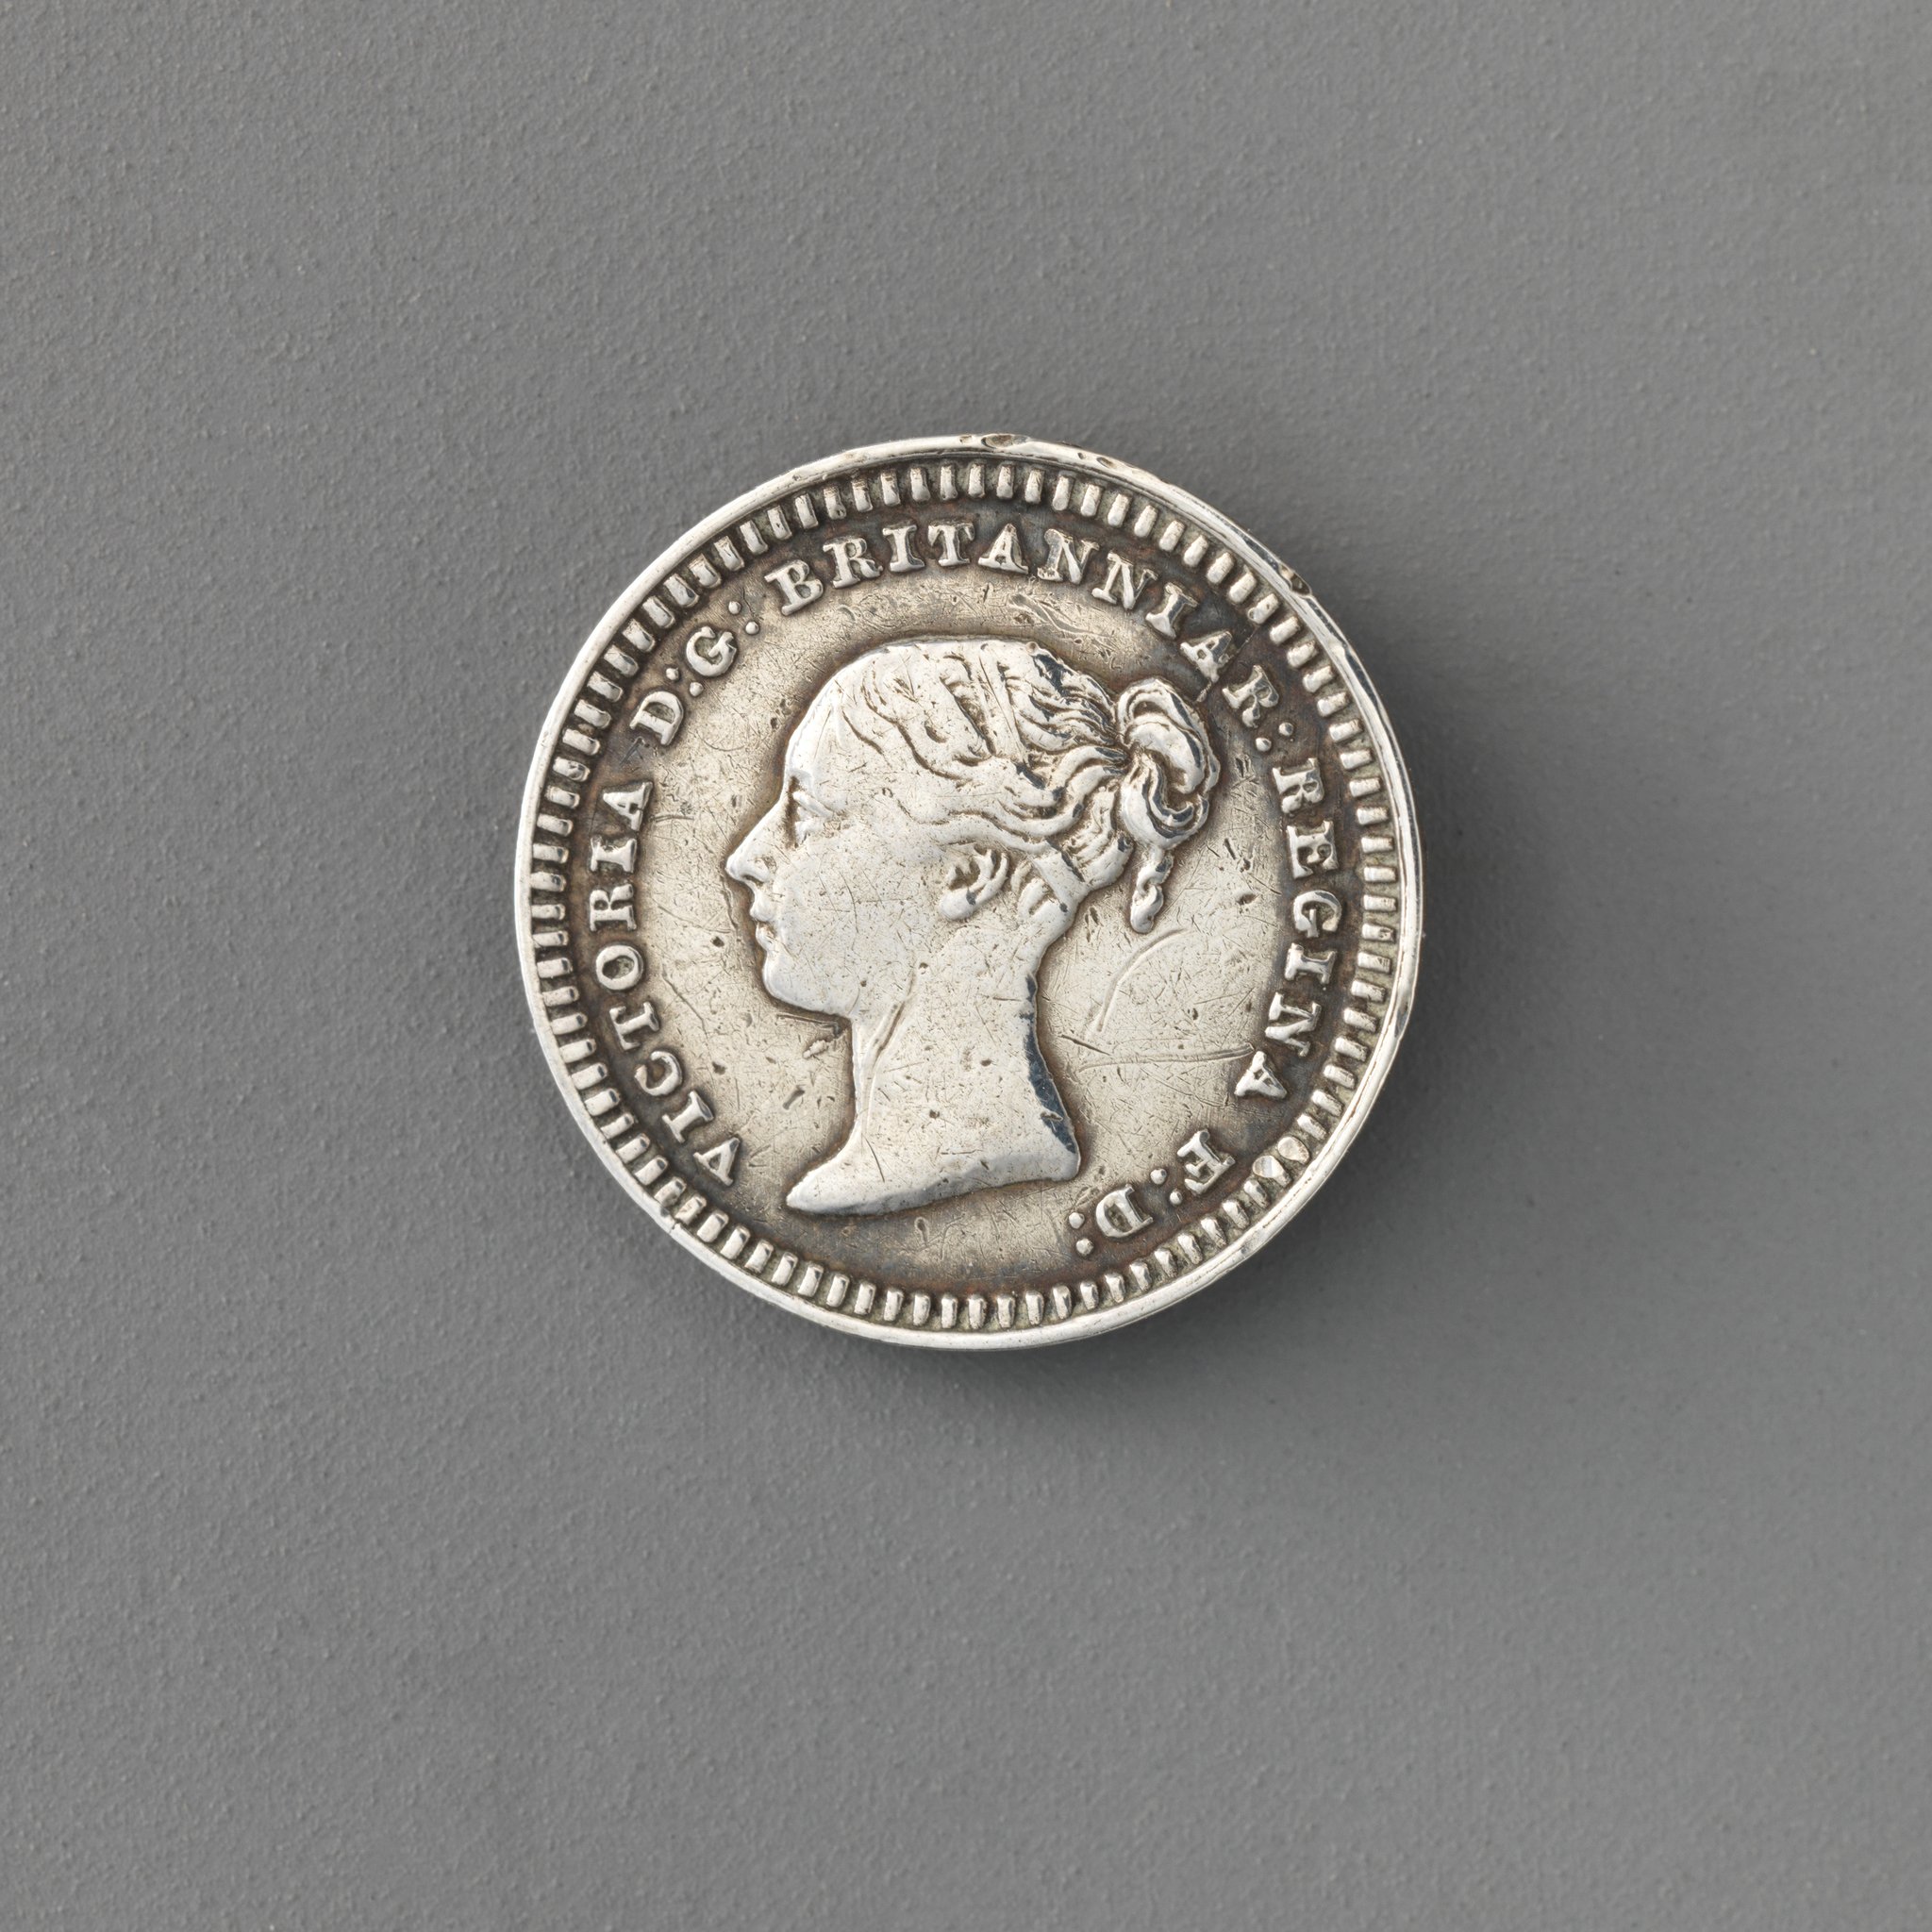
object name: half penny coin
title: Three half pence of Queen Victoria, 1838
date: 1838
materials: silver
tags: profiles,women,money,queen victoria